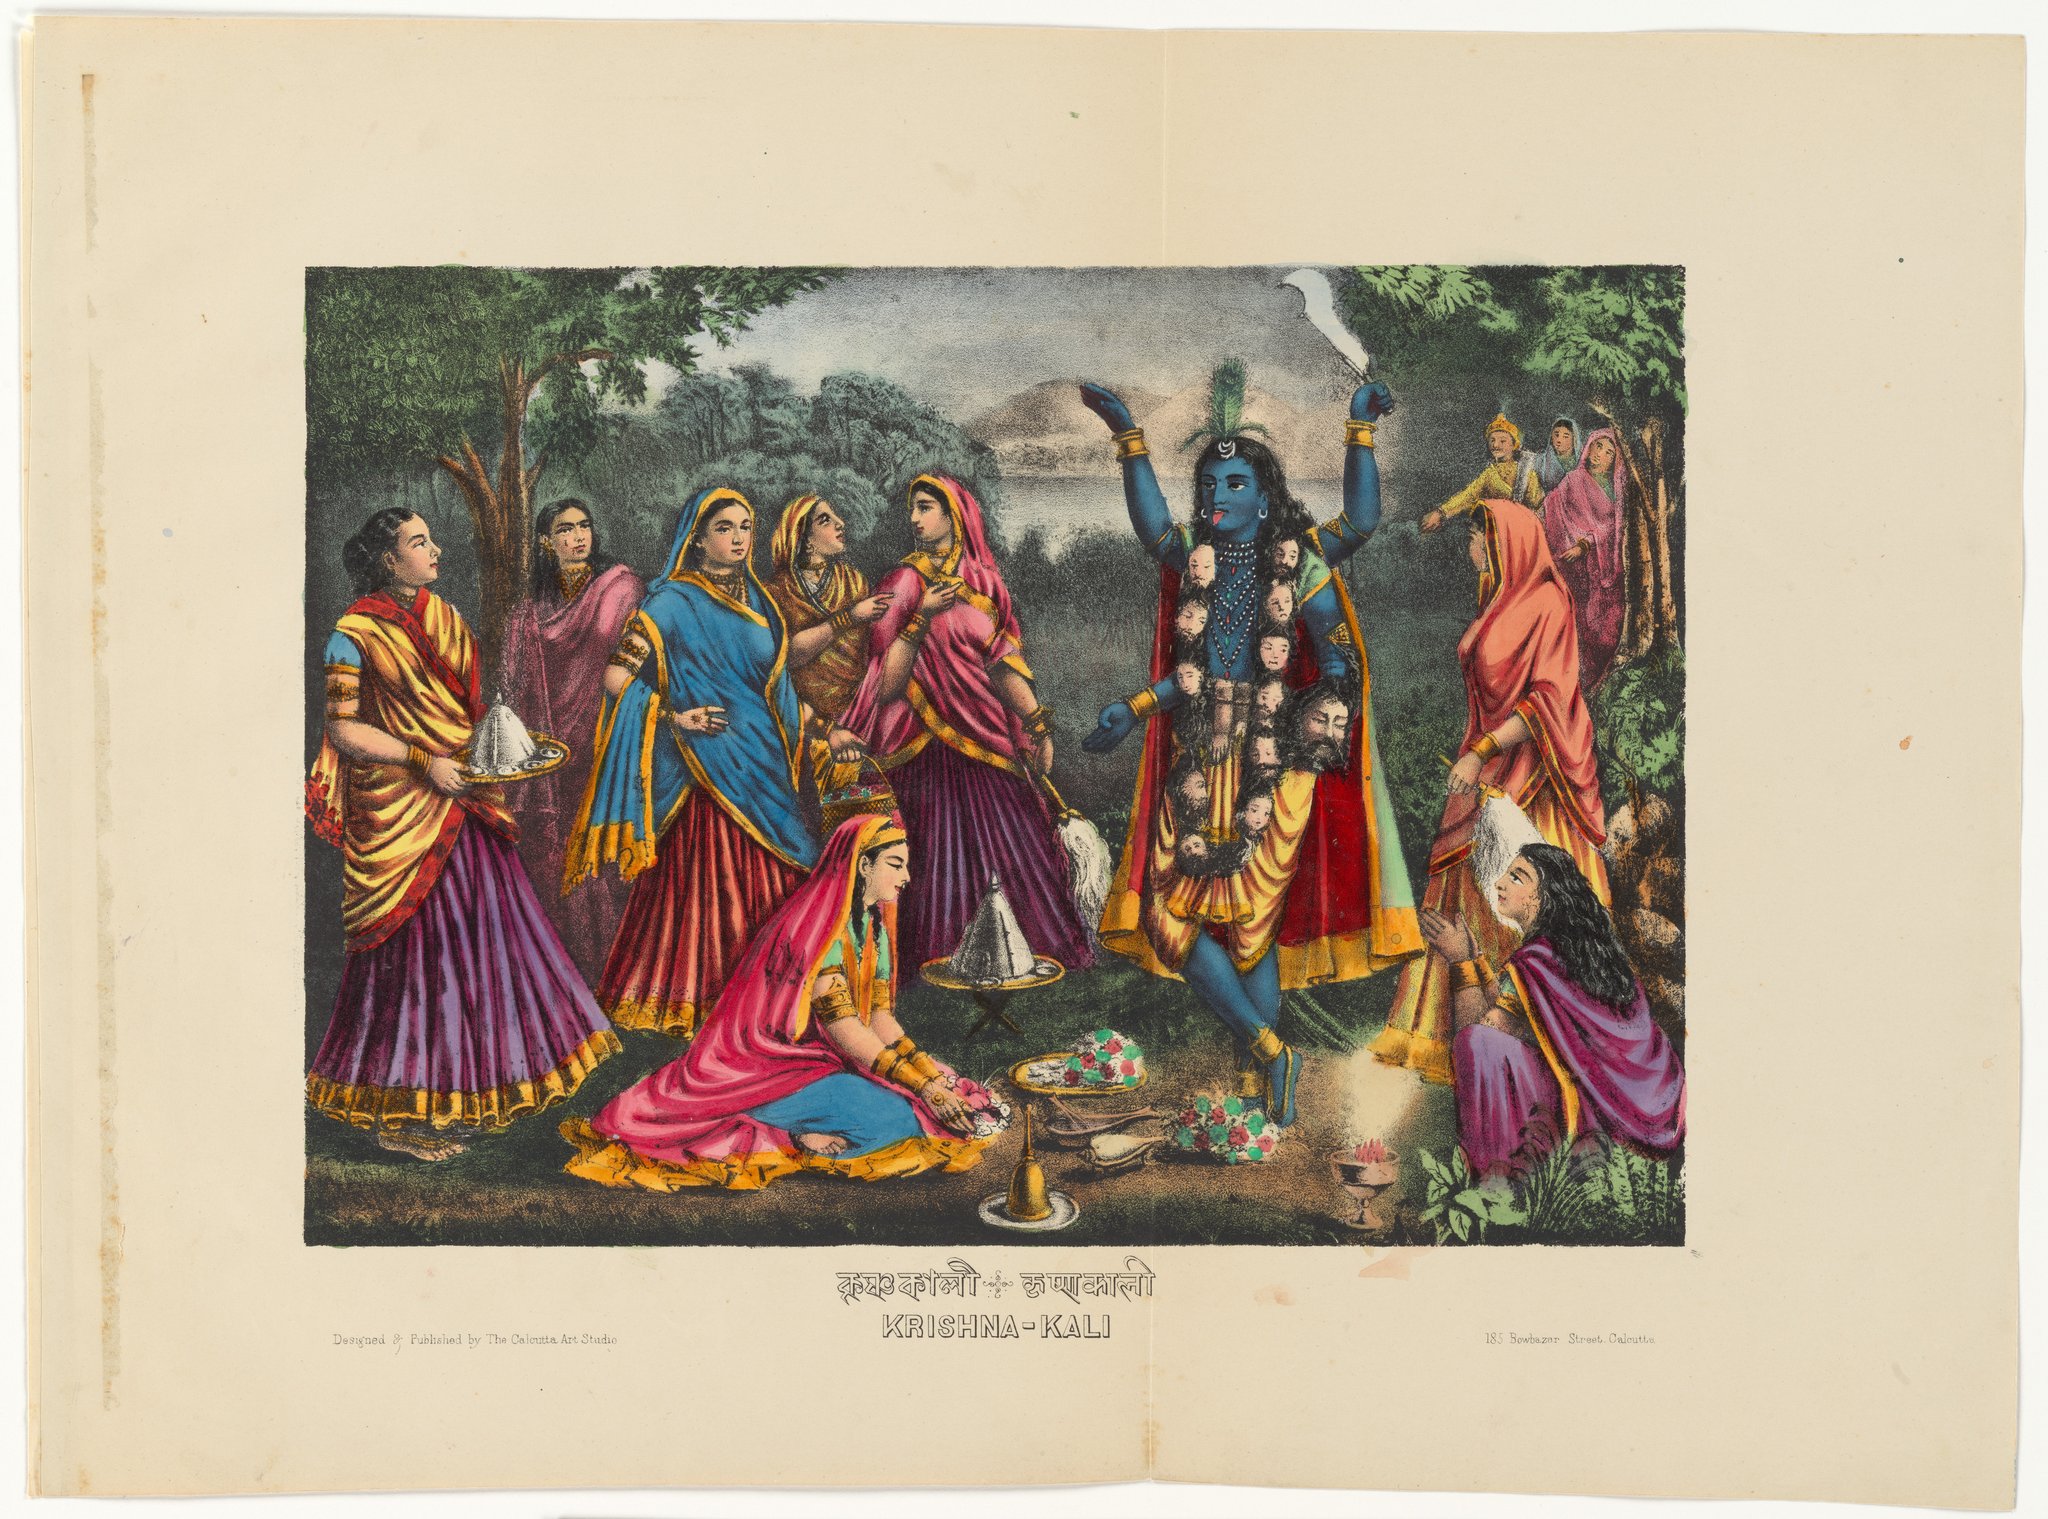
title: Krishna-Kali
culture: west bengali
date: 1878-1883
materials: glaze, watercolor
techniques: hand coloring, lithograph, printing